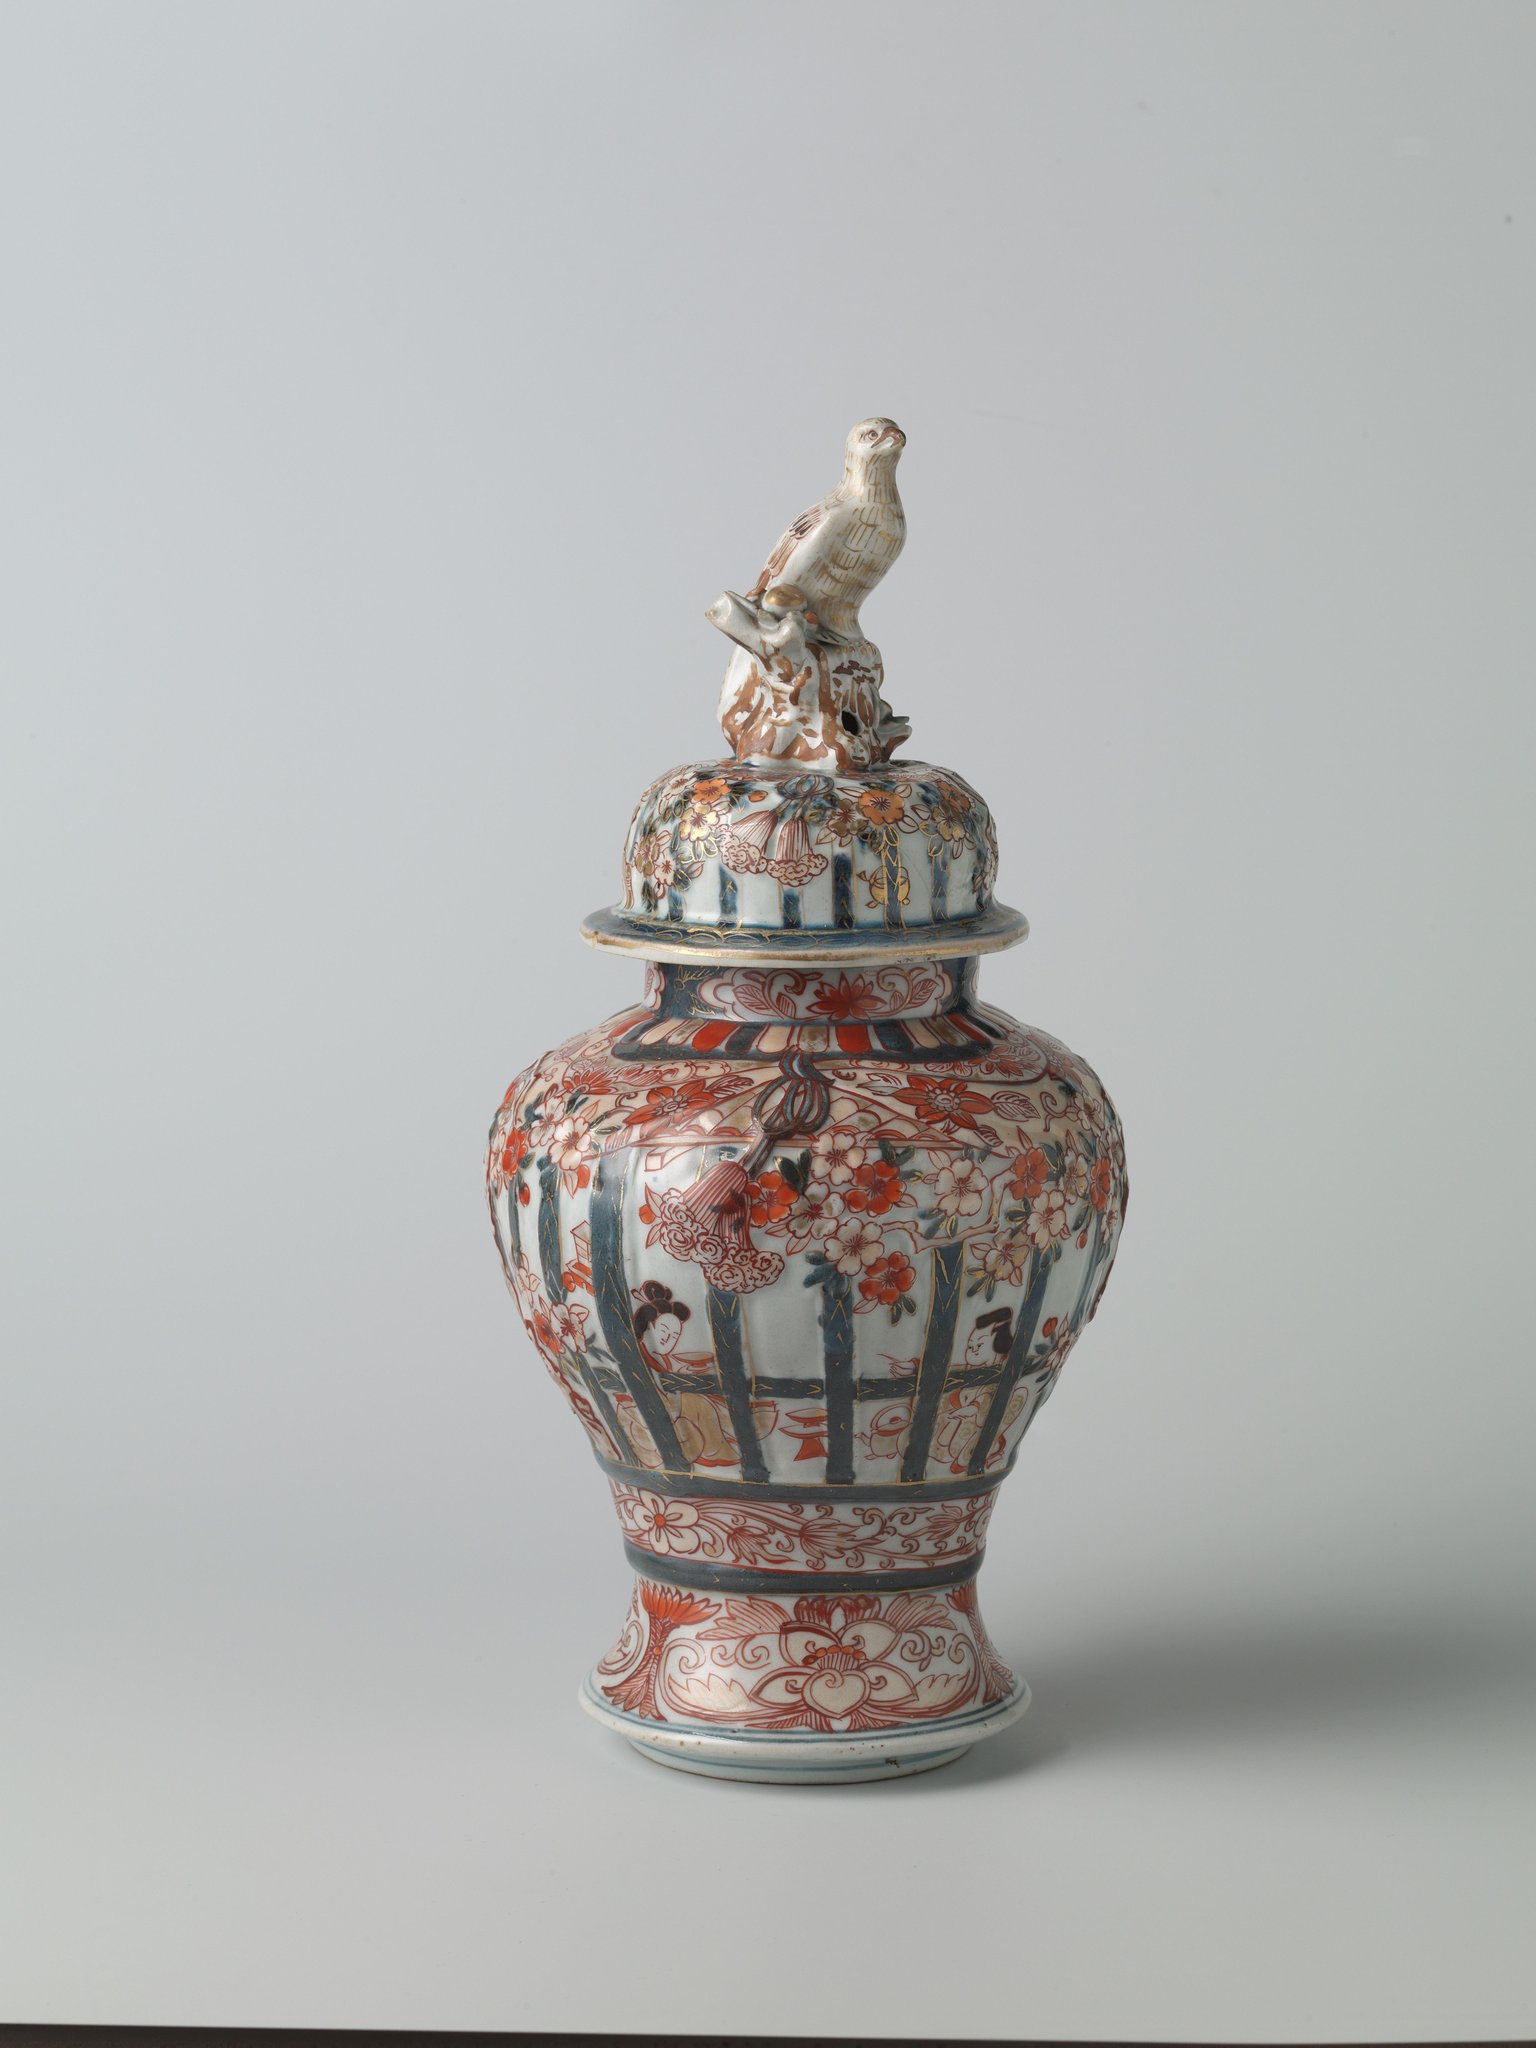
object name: covered jar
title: Covered baluster jar with figures in an interior behind framework, prunus trees and floral scrolls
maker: Anonymous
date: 1650-1699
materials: cobalt, glaze, gold, paint, porcelain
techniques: firing, gilding, turning, vitrification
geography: japan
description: Deksel van balustervormige dekselpot van porselein, beschilderd in onderglazuur blauw en op het glazuur rood, zwart en goud. Op de wand beschilderd traliewerk, versierd met gemodelleerde en gedecoreerde prunusbomen en banden met bloemranken. Onder het traliewerk een band met bloemranken. Rond de voet een band met lotusranken. Dekselknop in de vorm van een vogel op een stronk. Imari.